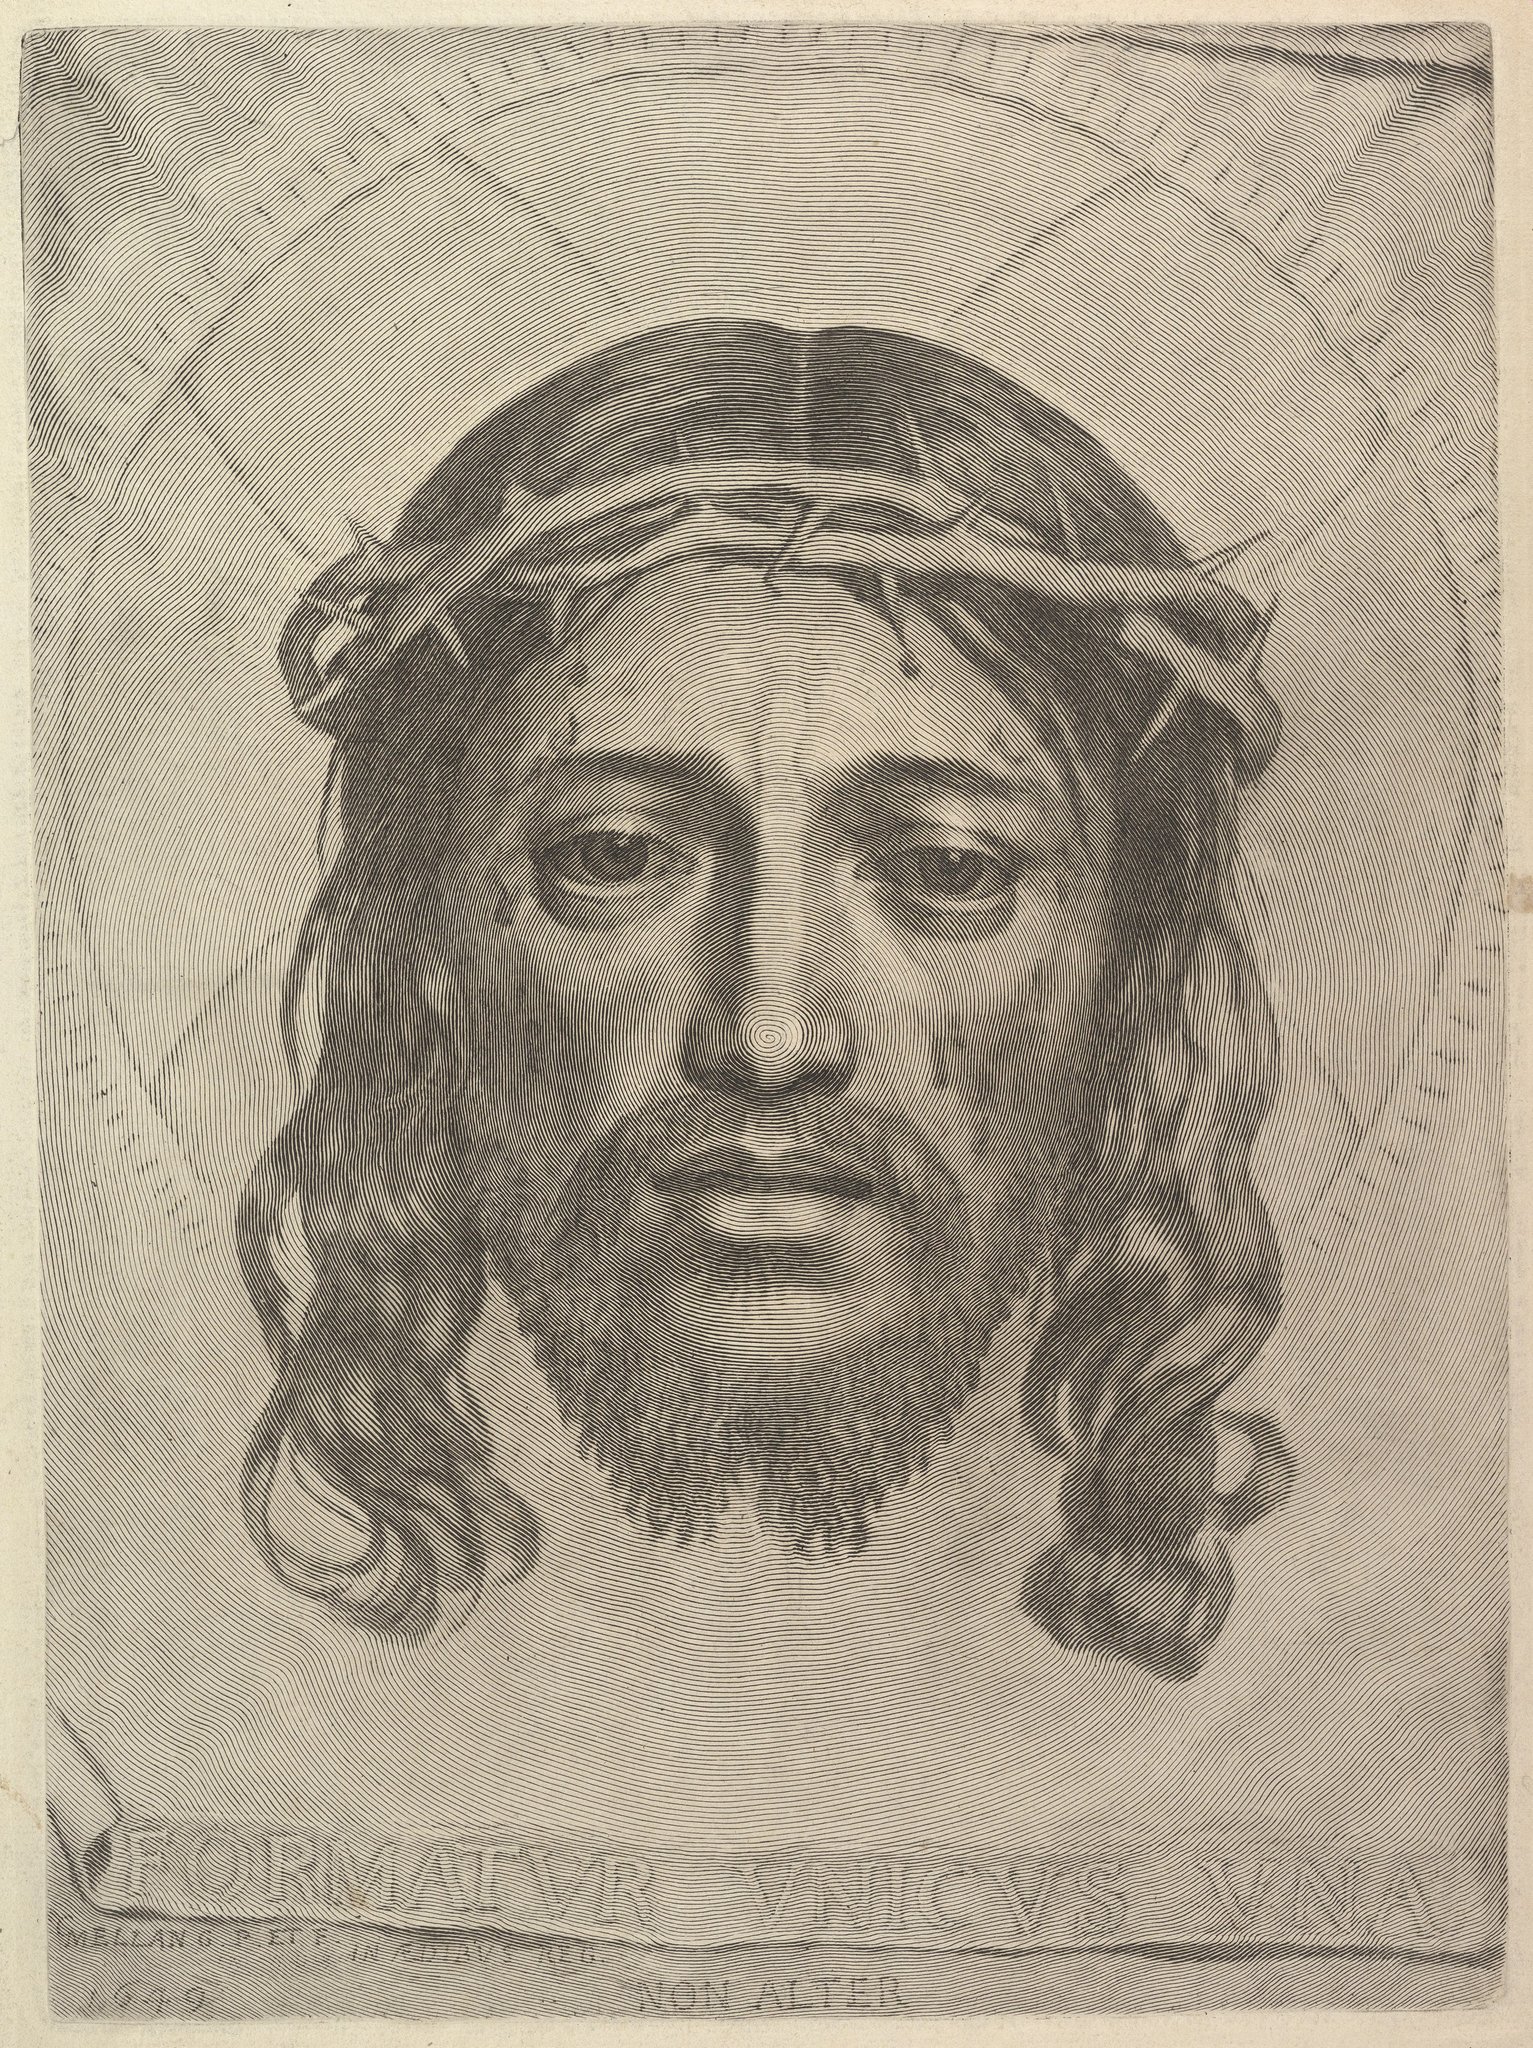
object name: print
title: Face of Christ on St. Veronica's Cloth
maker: claude mellan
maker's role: artist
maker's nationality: french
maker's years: 1598-1688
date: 1649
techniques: engraving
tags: faces,christ